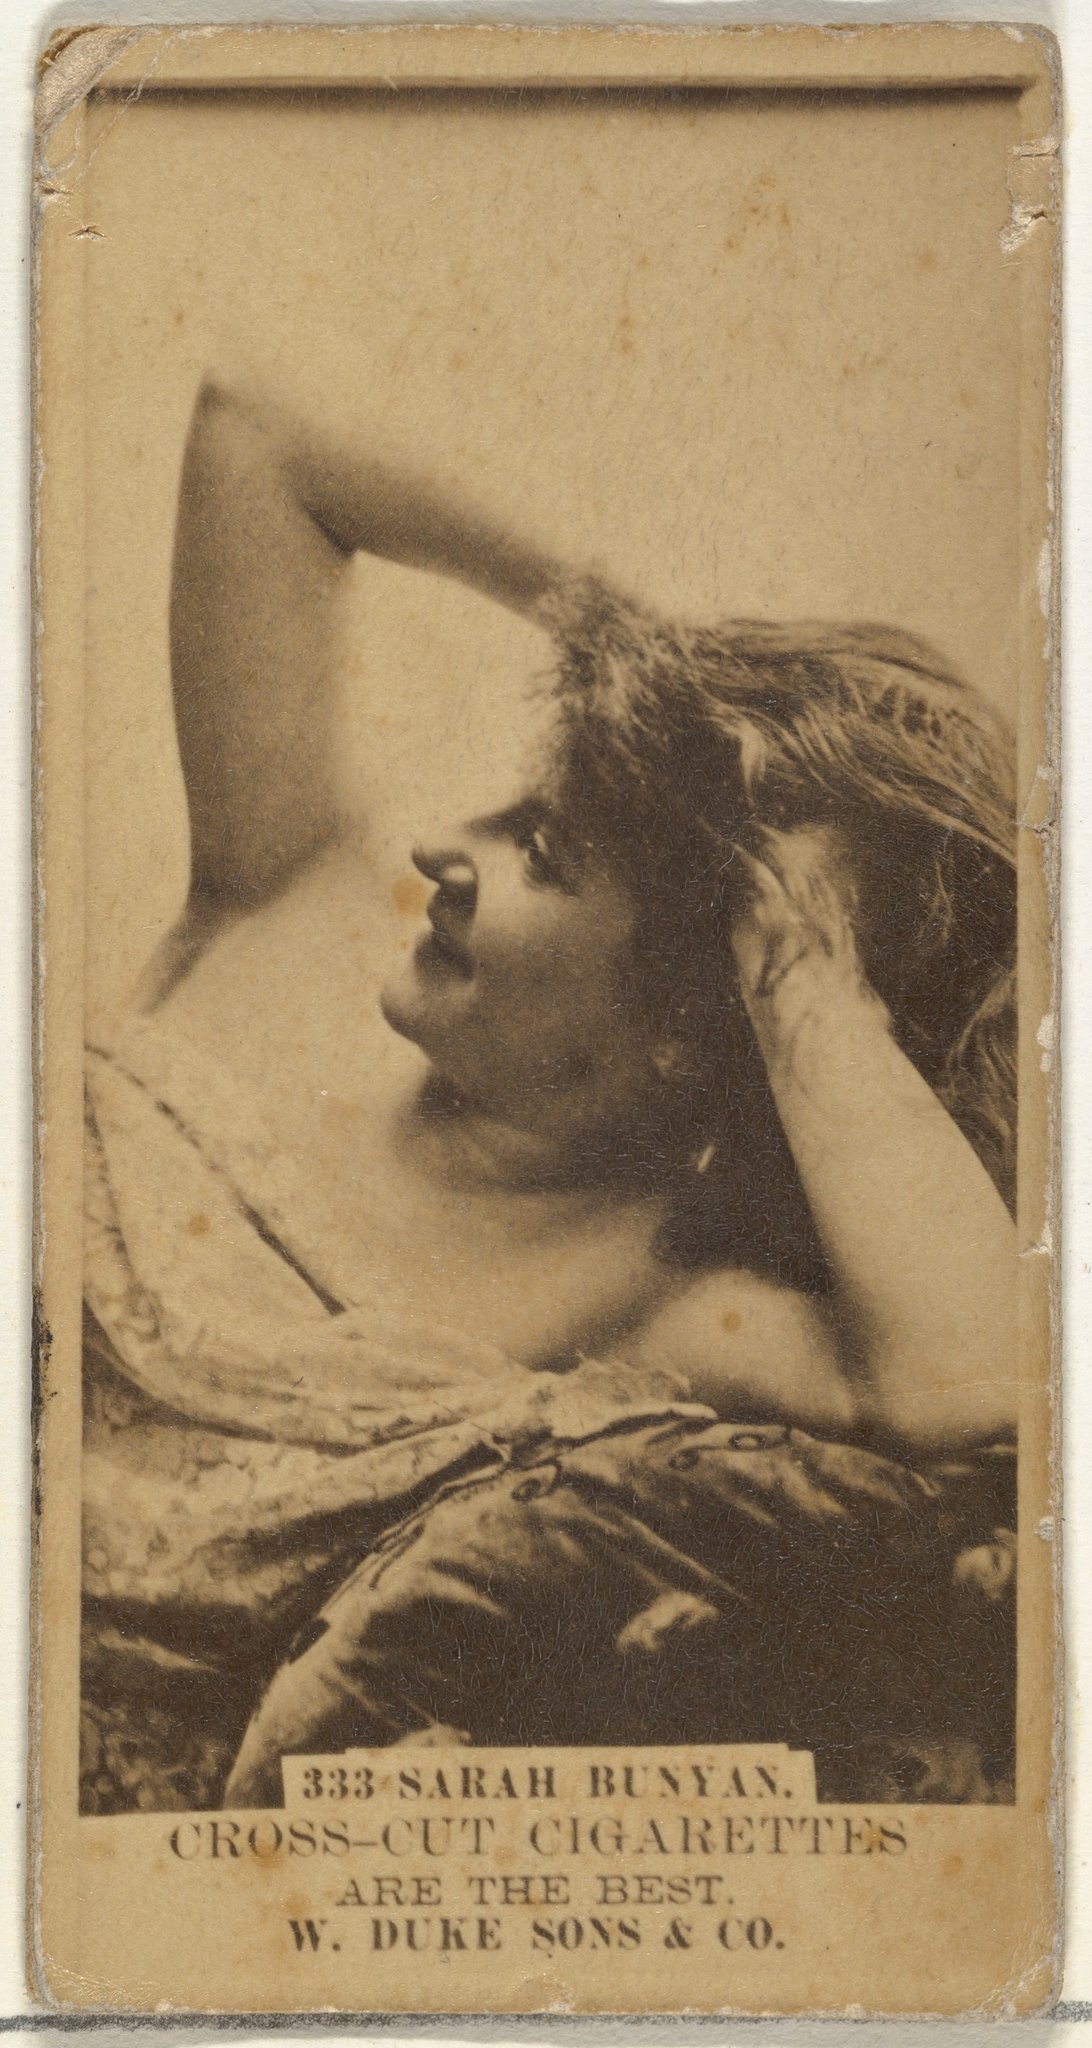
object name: photograph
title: Card Number 333, Sarah Bunyan, from the Actors and Actresses series (N145-3) issued by Duke Sons & Co. to promote Cross Cut Cigarettes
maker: w. duke, sons & co.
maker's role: publisher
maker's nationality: american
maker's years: 1870-1920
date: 1880-1889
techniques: albumen silver print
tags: women,actresses